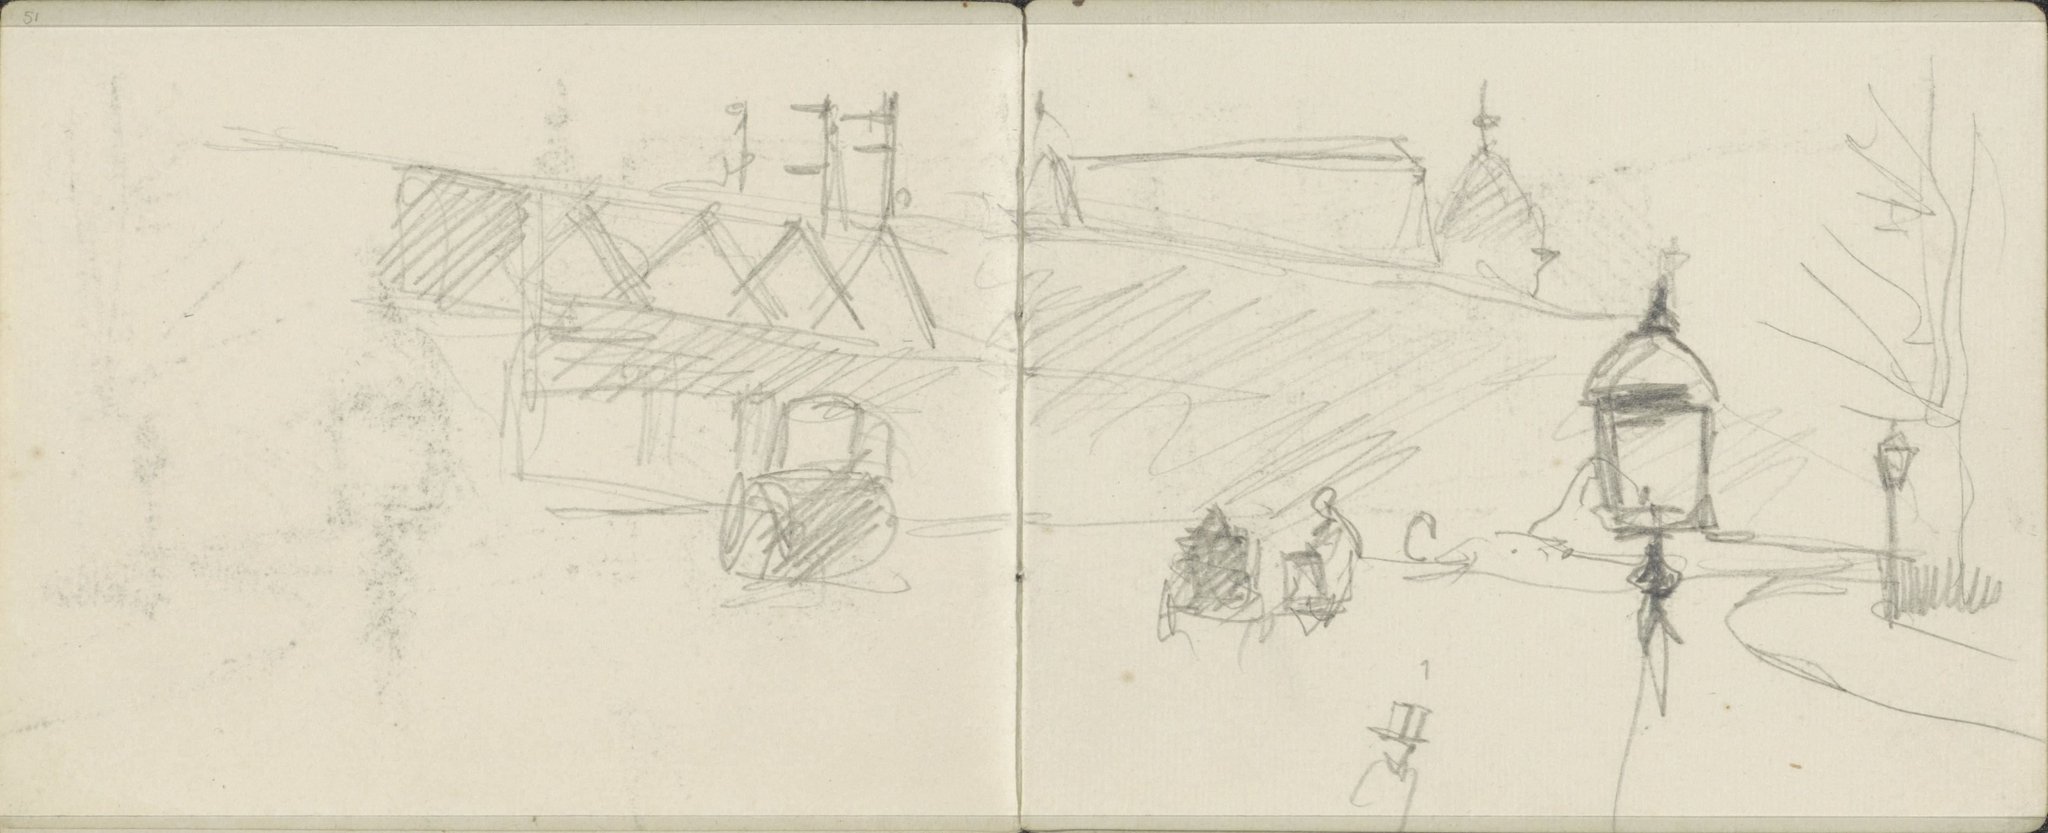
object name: sketchbook leaf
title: Gezicht op een straat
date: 1886-1895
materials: paper, pencil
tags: street (+ city(-scape) with figures, staffage), london, amsterdam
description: Pagina 51 en pagina 52 uit een schetsboek met 34 bladen.